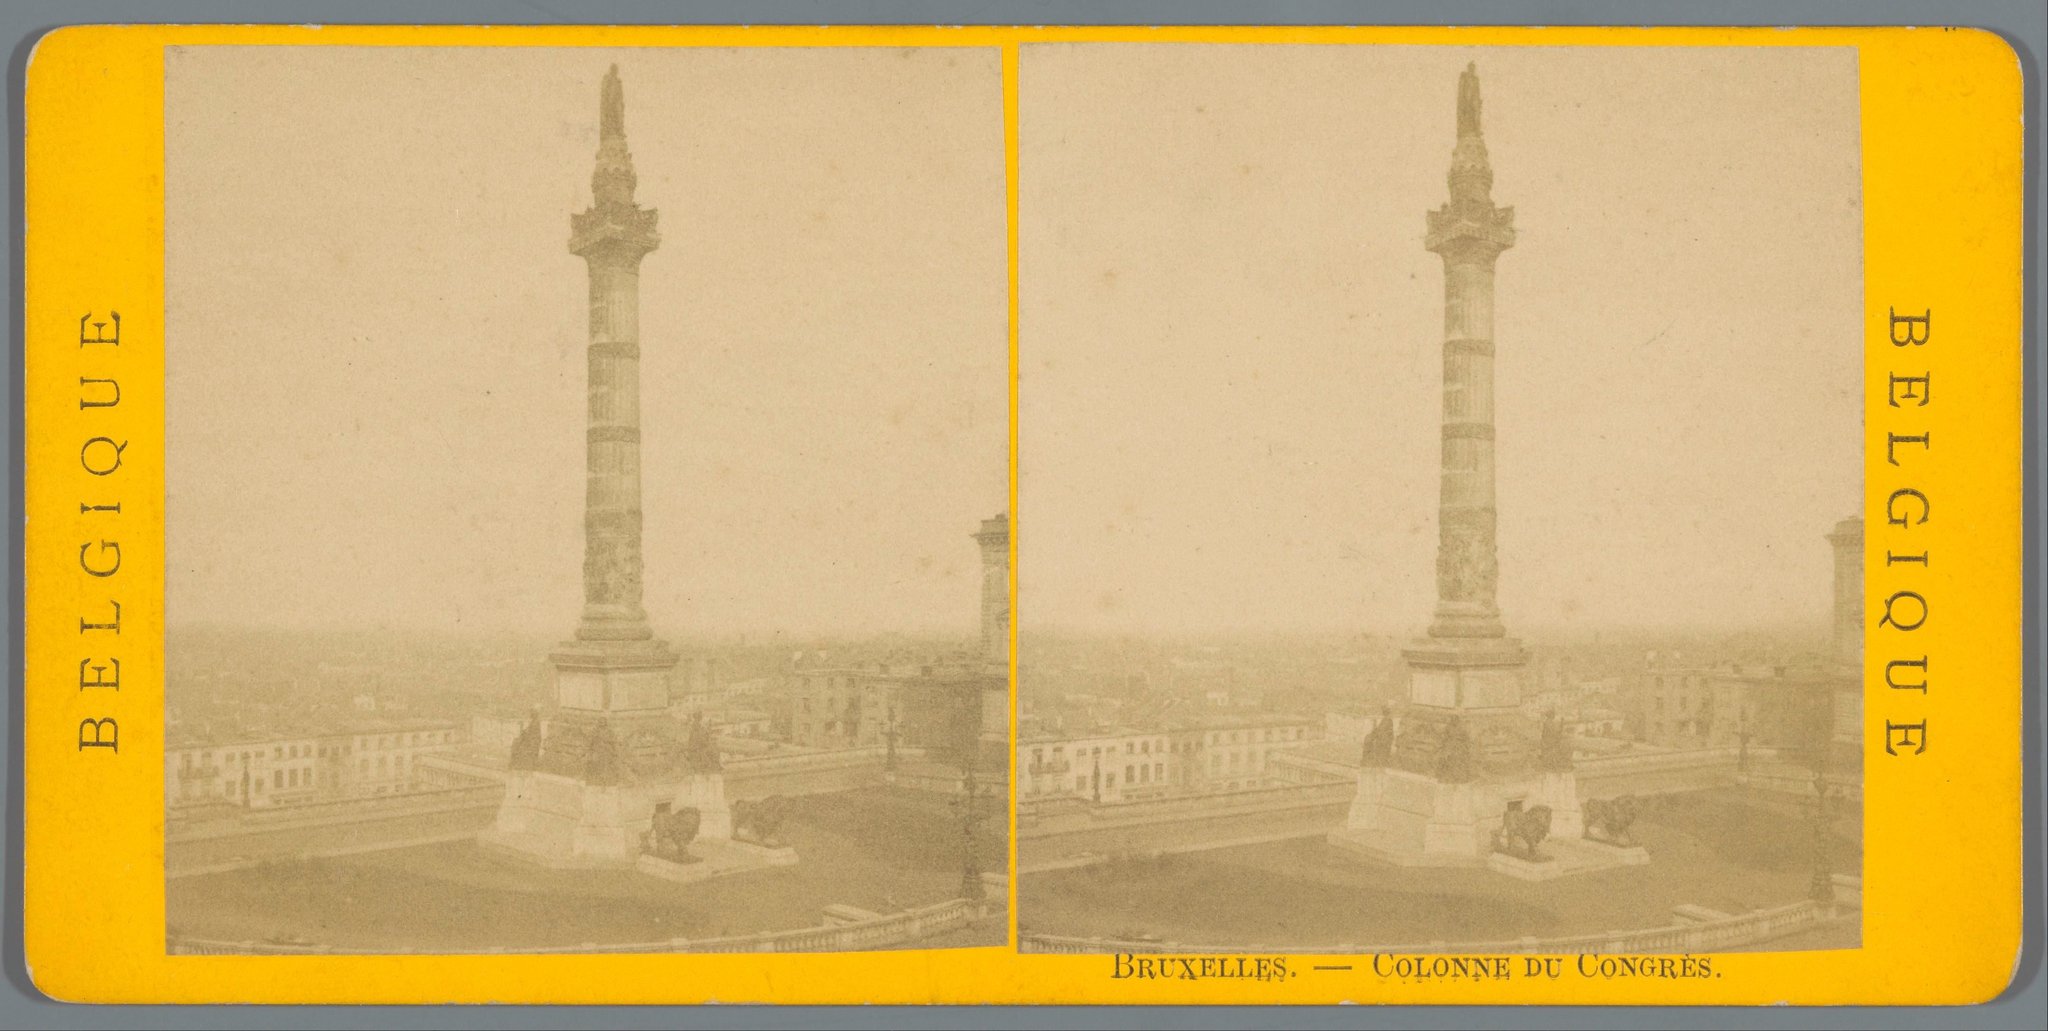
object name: stereograph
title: Belgique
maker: Anonymous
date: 1876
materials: cardboard, paper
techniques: albumen print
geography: brussels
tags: monument, statue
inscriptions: inscription: ‘4/16 Juli 1876’, inscription: ‘No. 15’, inscription: ‘7’